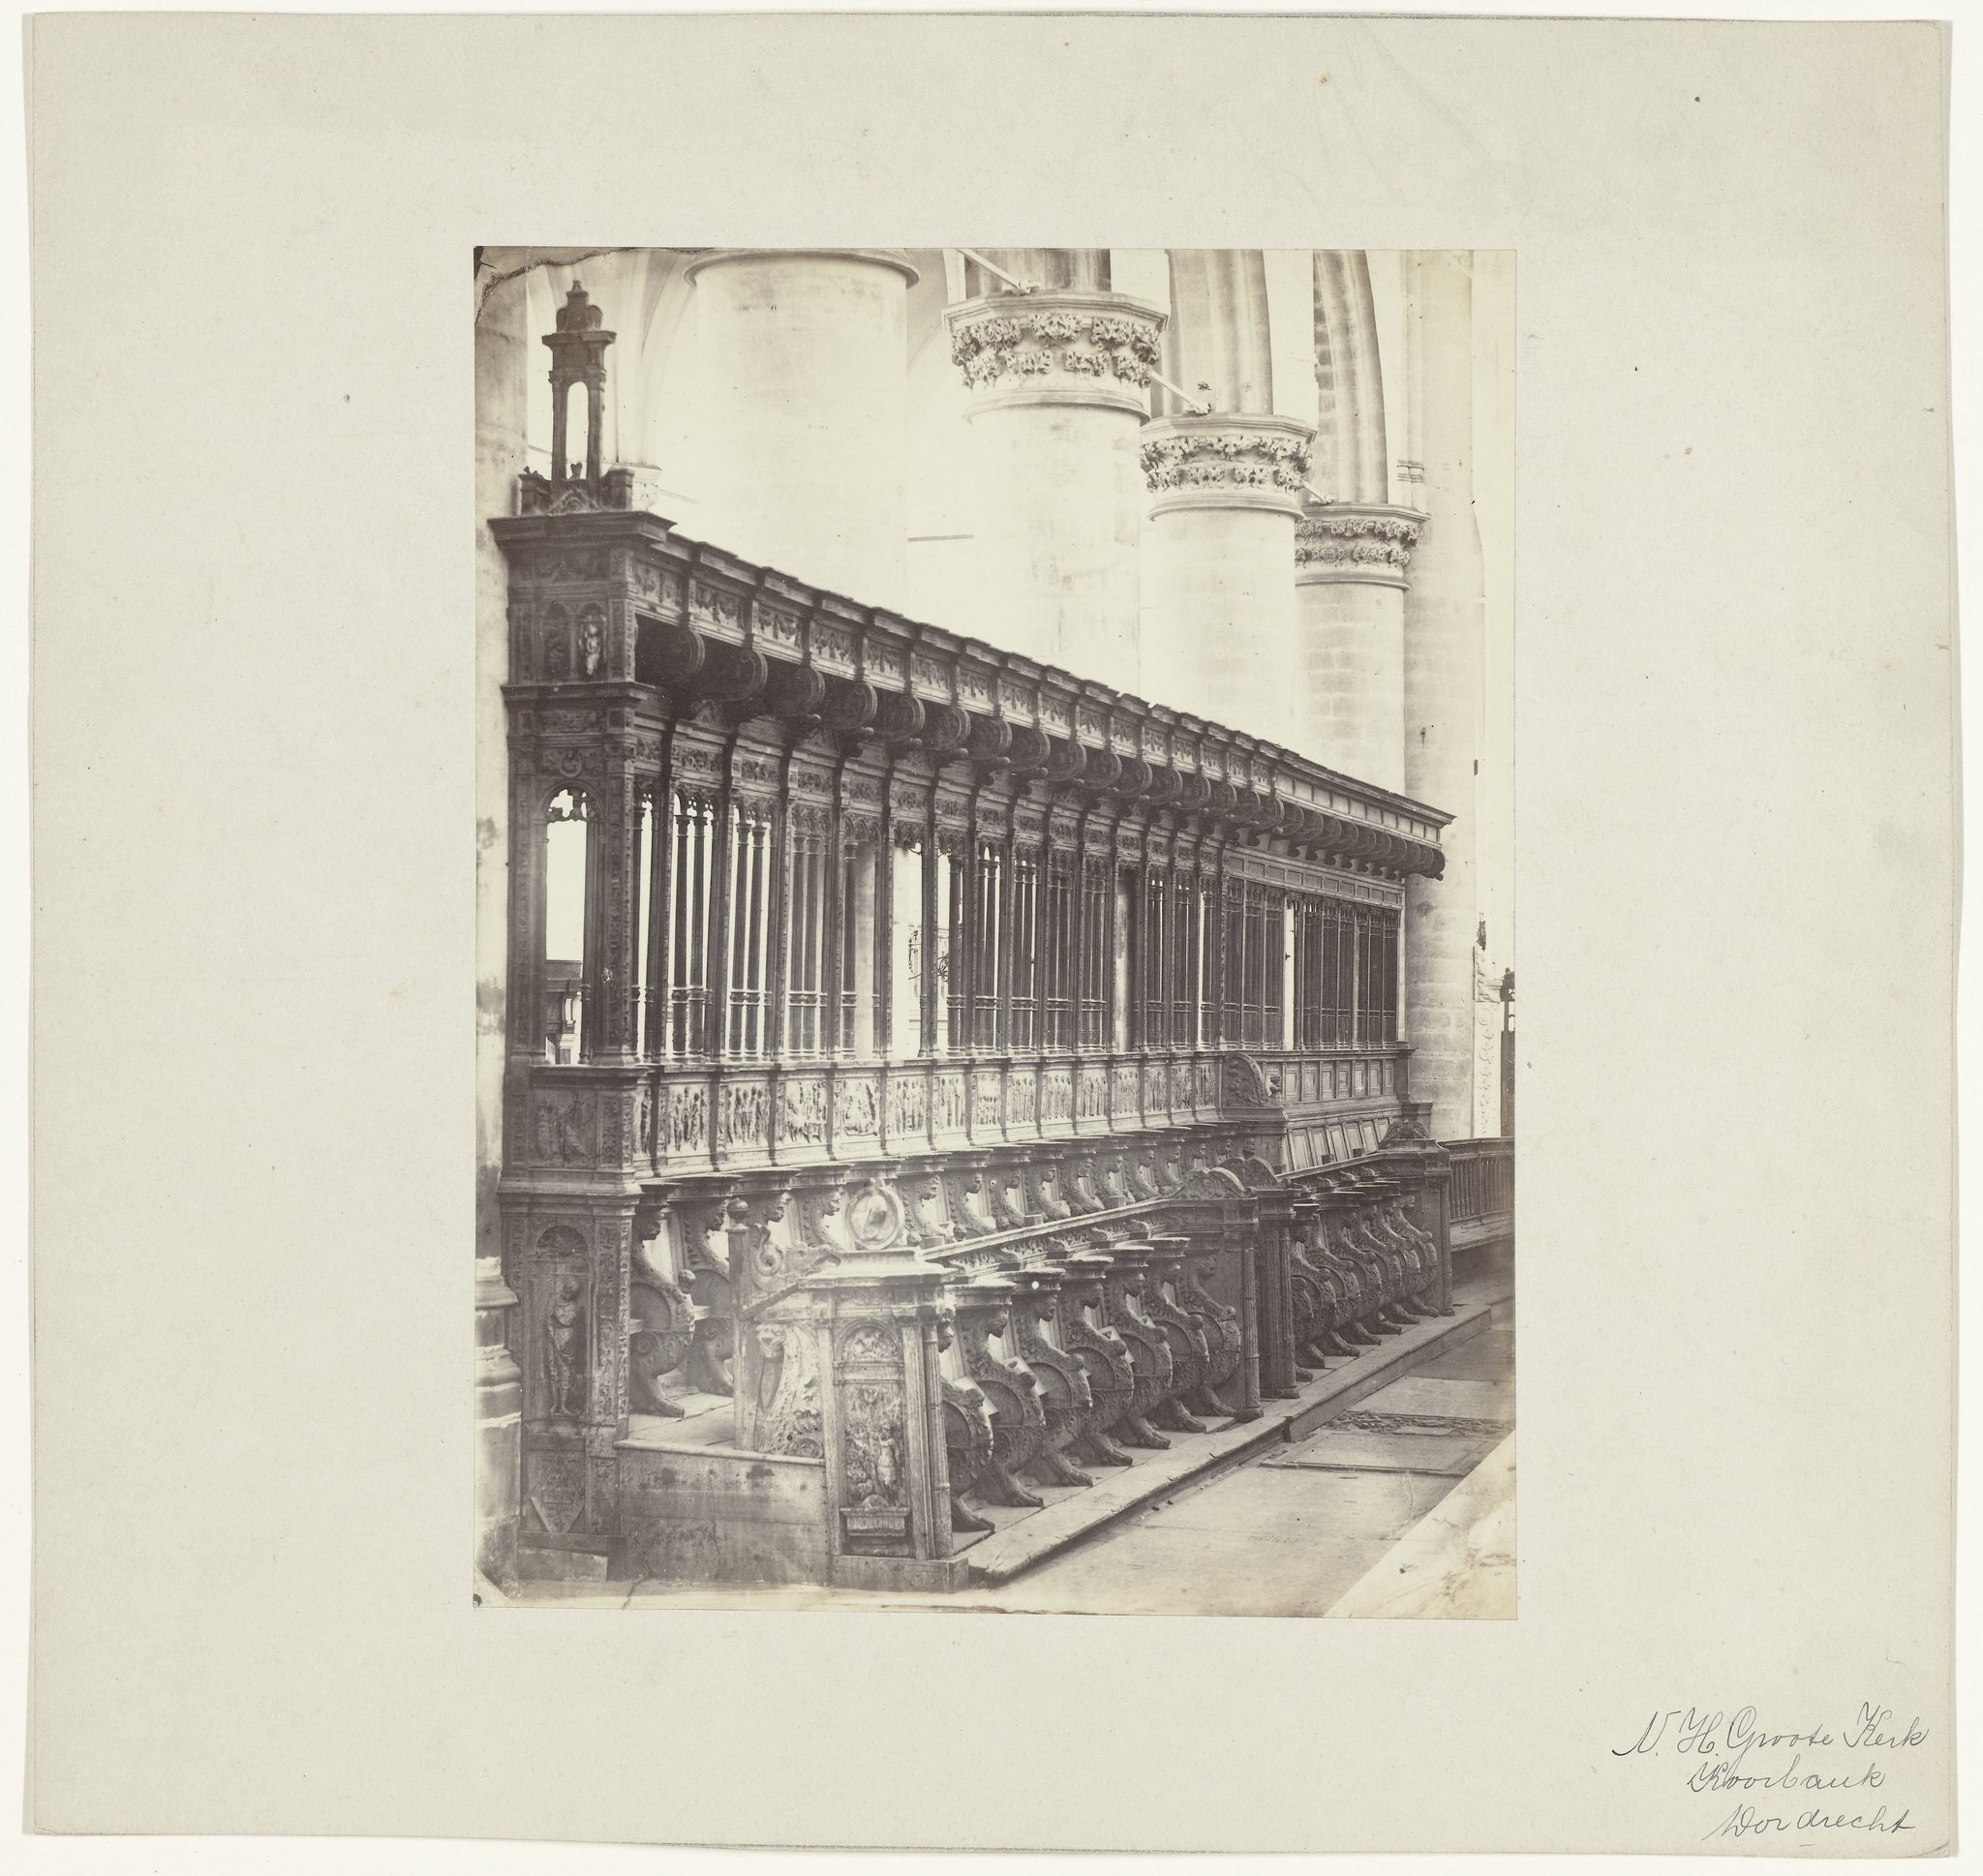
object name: photograph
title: N.H. Groote Kerk Koorbank Dordrecht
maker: Anonymous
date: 1890-1920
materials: cardboard, paper, photographic support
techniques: albumen print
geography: dordrecht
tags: parts of church interior: choir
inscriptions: caption: ‘N.H. Groote Kerk/ Koorbank/ Dordrecht’